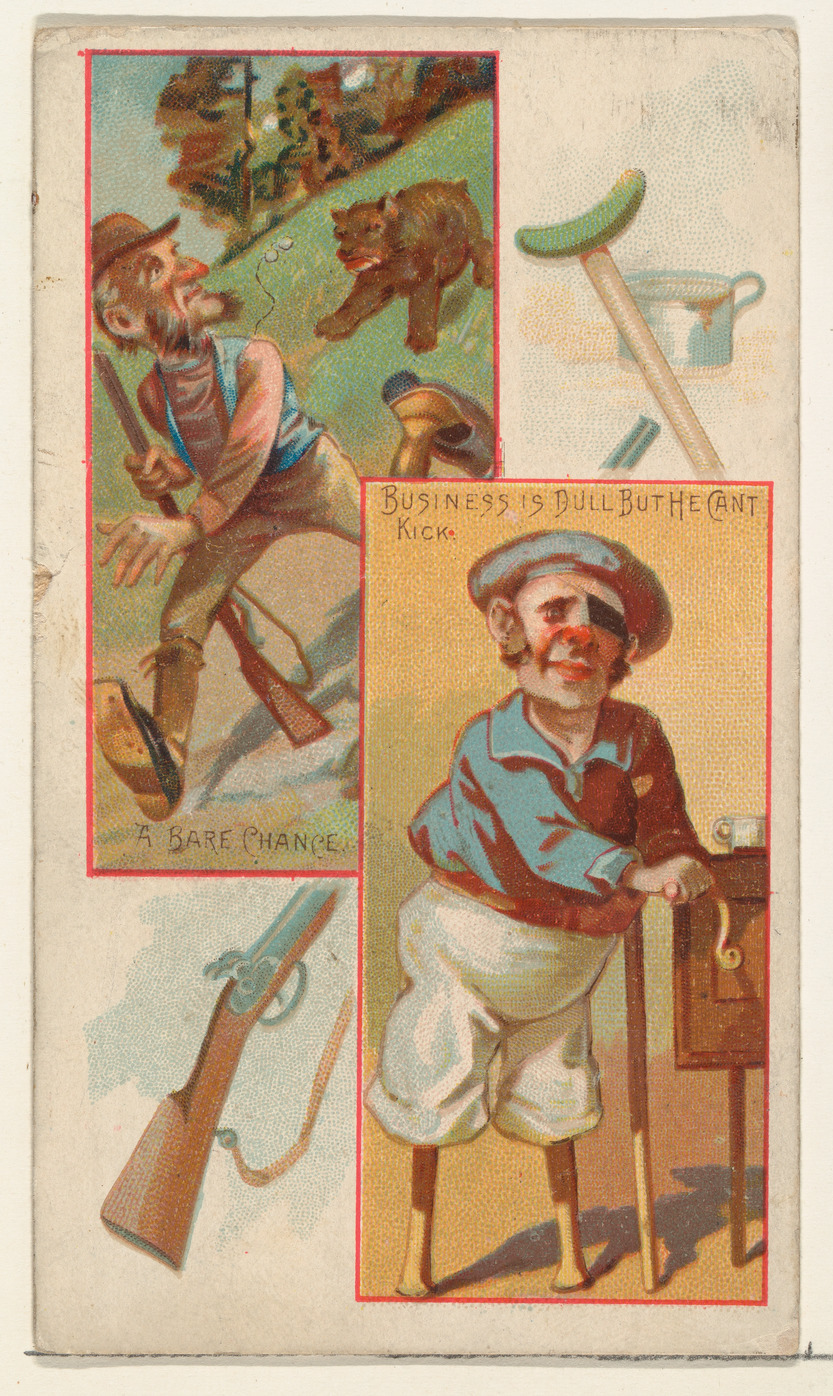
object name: print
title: A Bare Chance / Business is Dull But He Can't Kick, from the Jokes series (N118) issued by Duke Sons & Co. to promote Honest Long Cut Tobacco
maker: w. duke, sons & co.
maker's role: publisher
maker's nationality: american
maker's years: 1870-1920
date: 1891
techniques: color lithograph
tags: bears,men